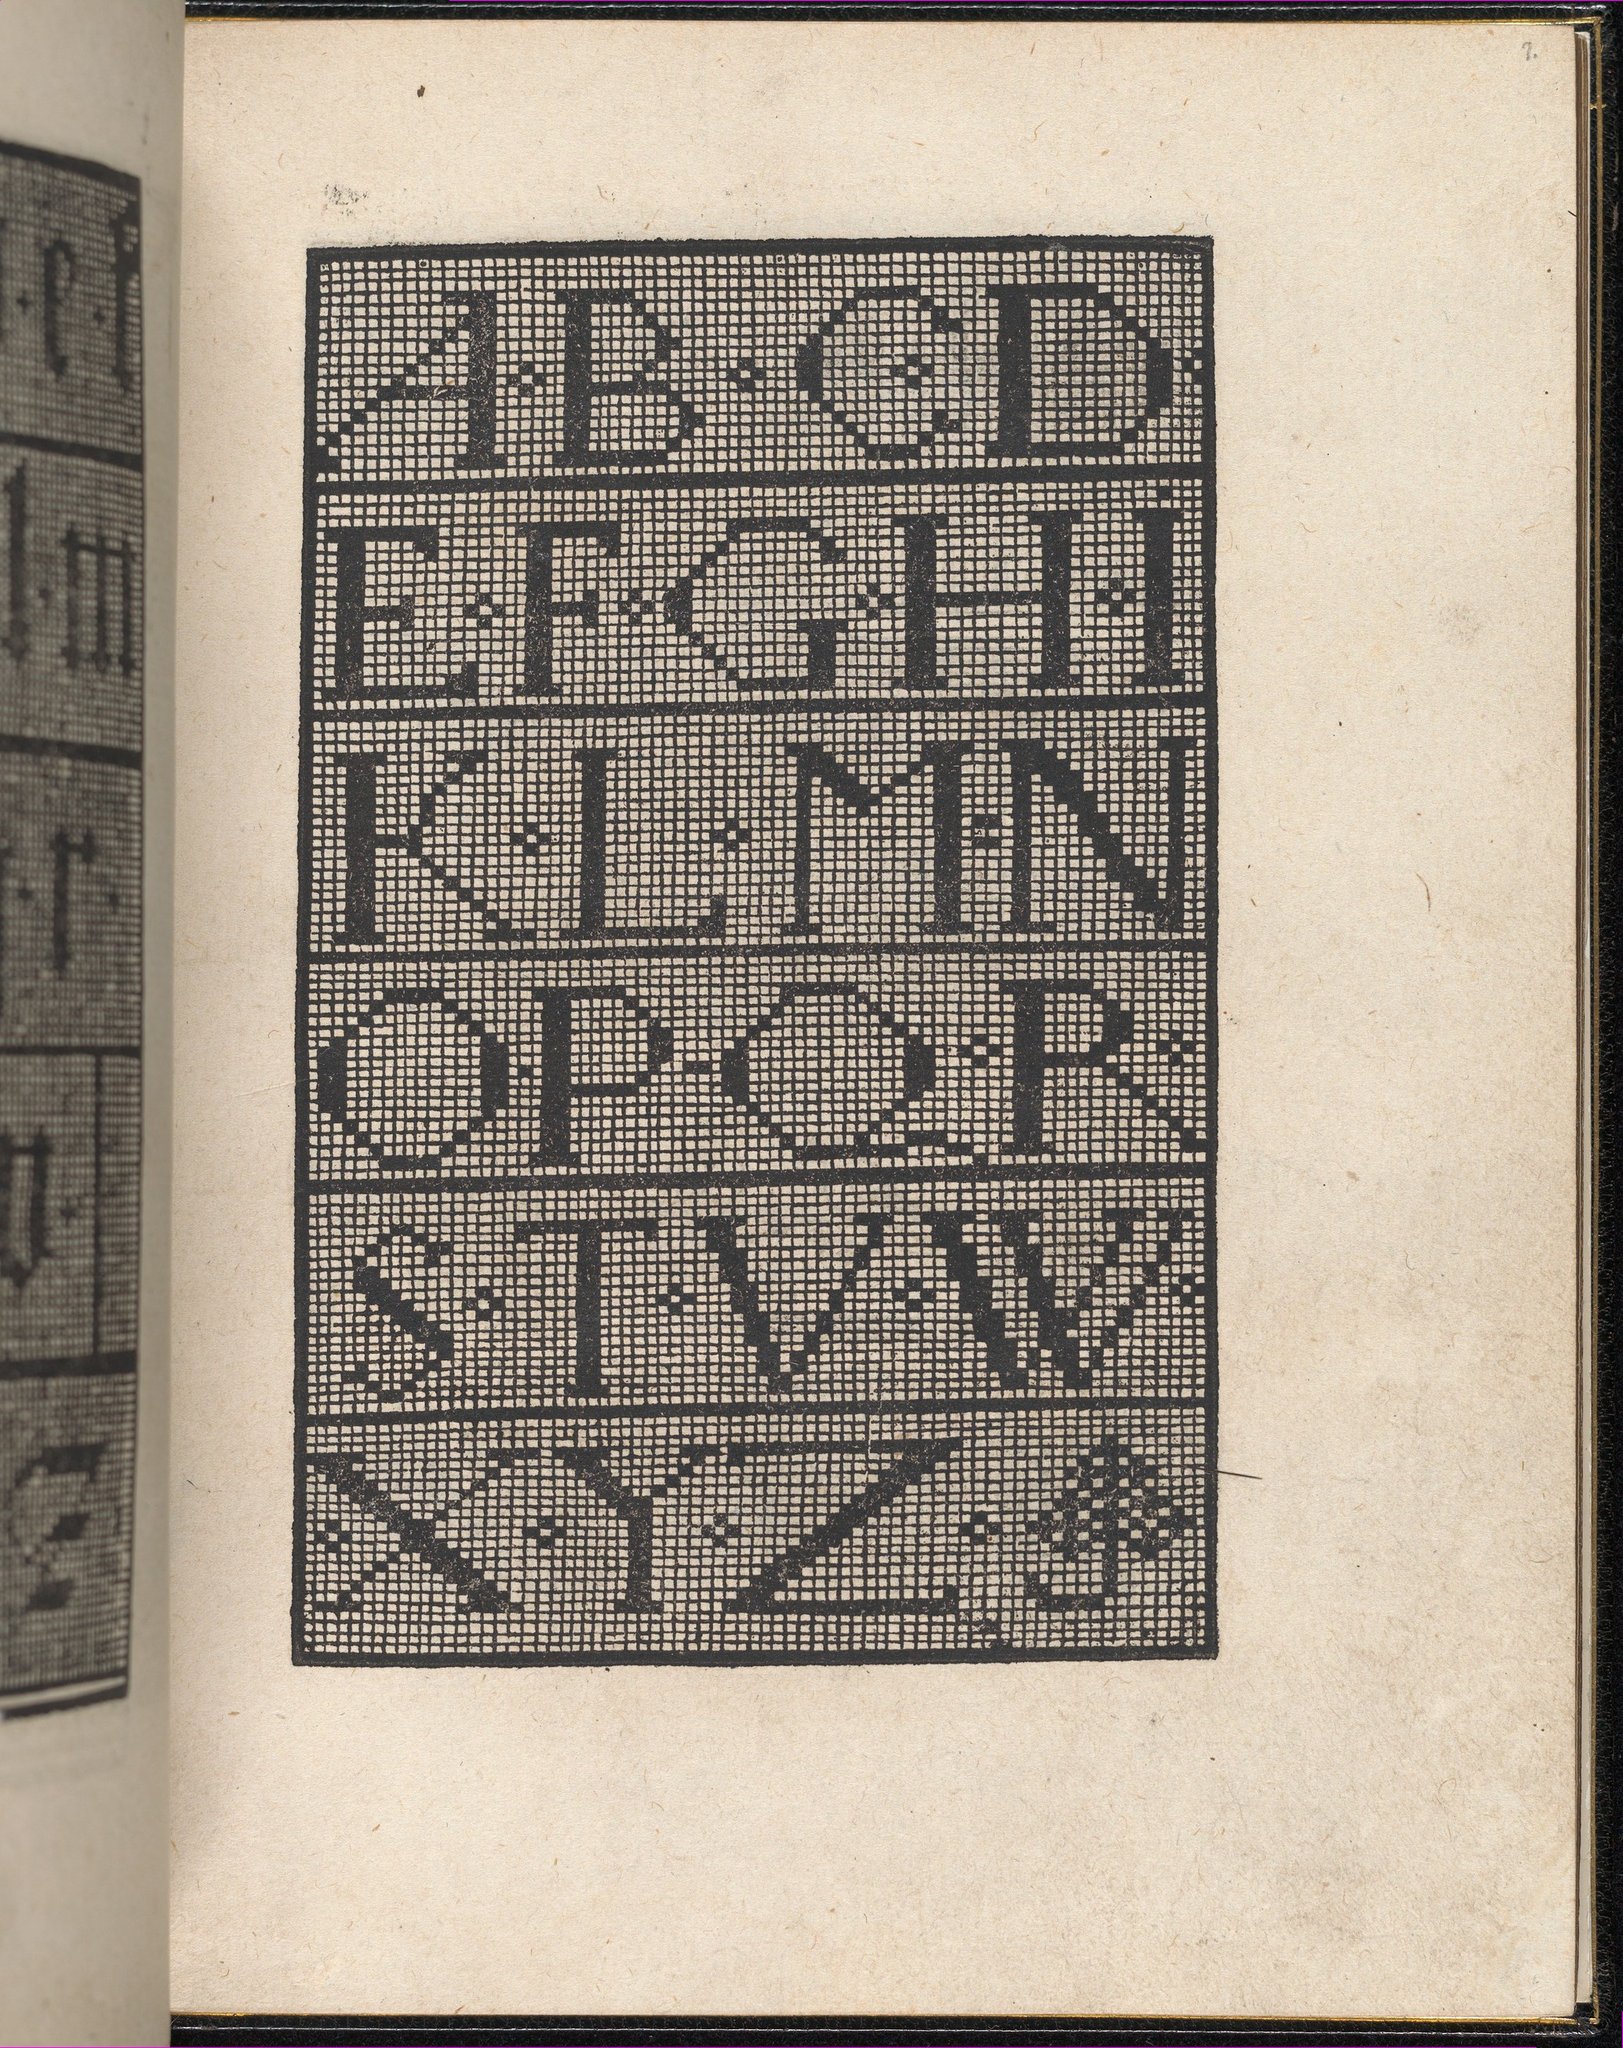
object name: book print ornament architecture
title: Page from Ein new kunstlich Modelbuch...(Page 7r)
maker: peter quentel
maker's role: publisher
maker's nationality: german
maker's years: 1500-1550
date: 1544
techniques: woodcut